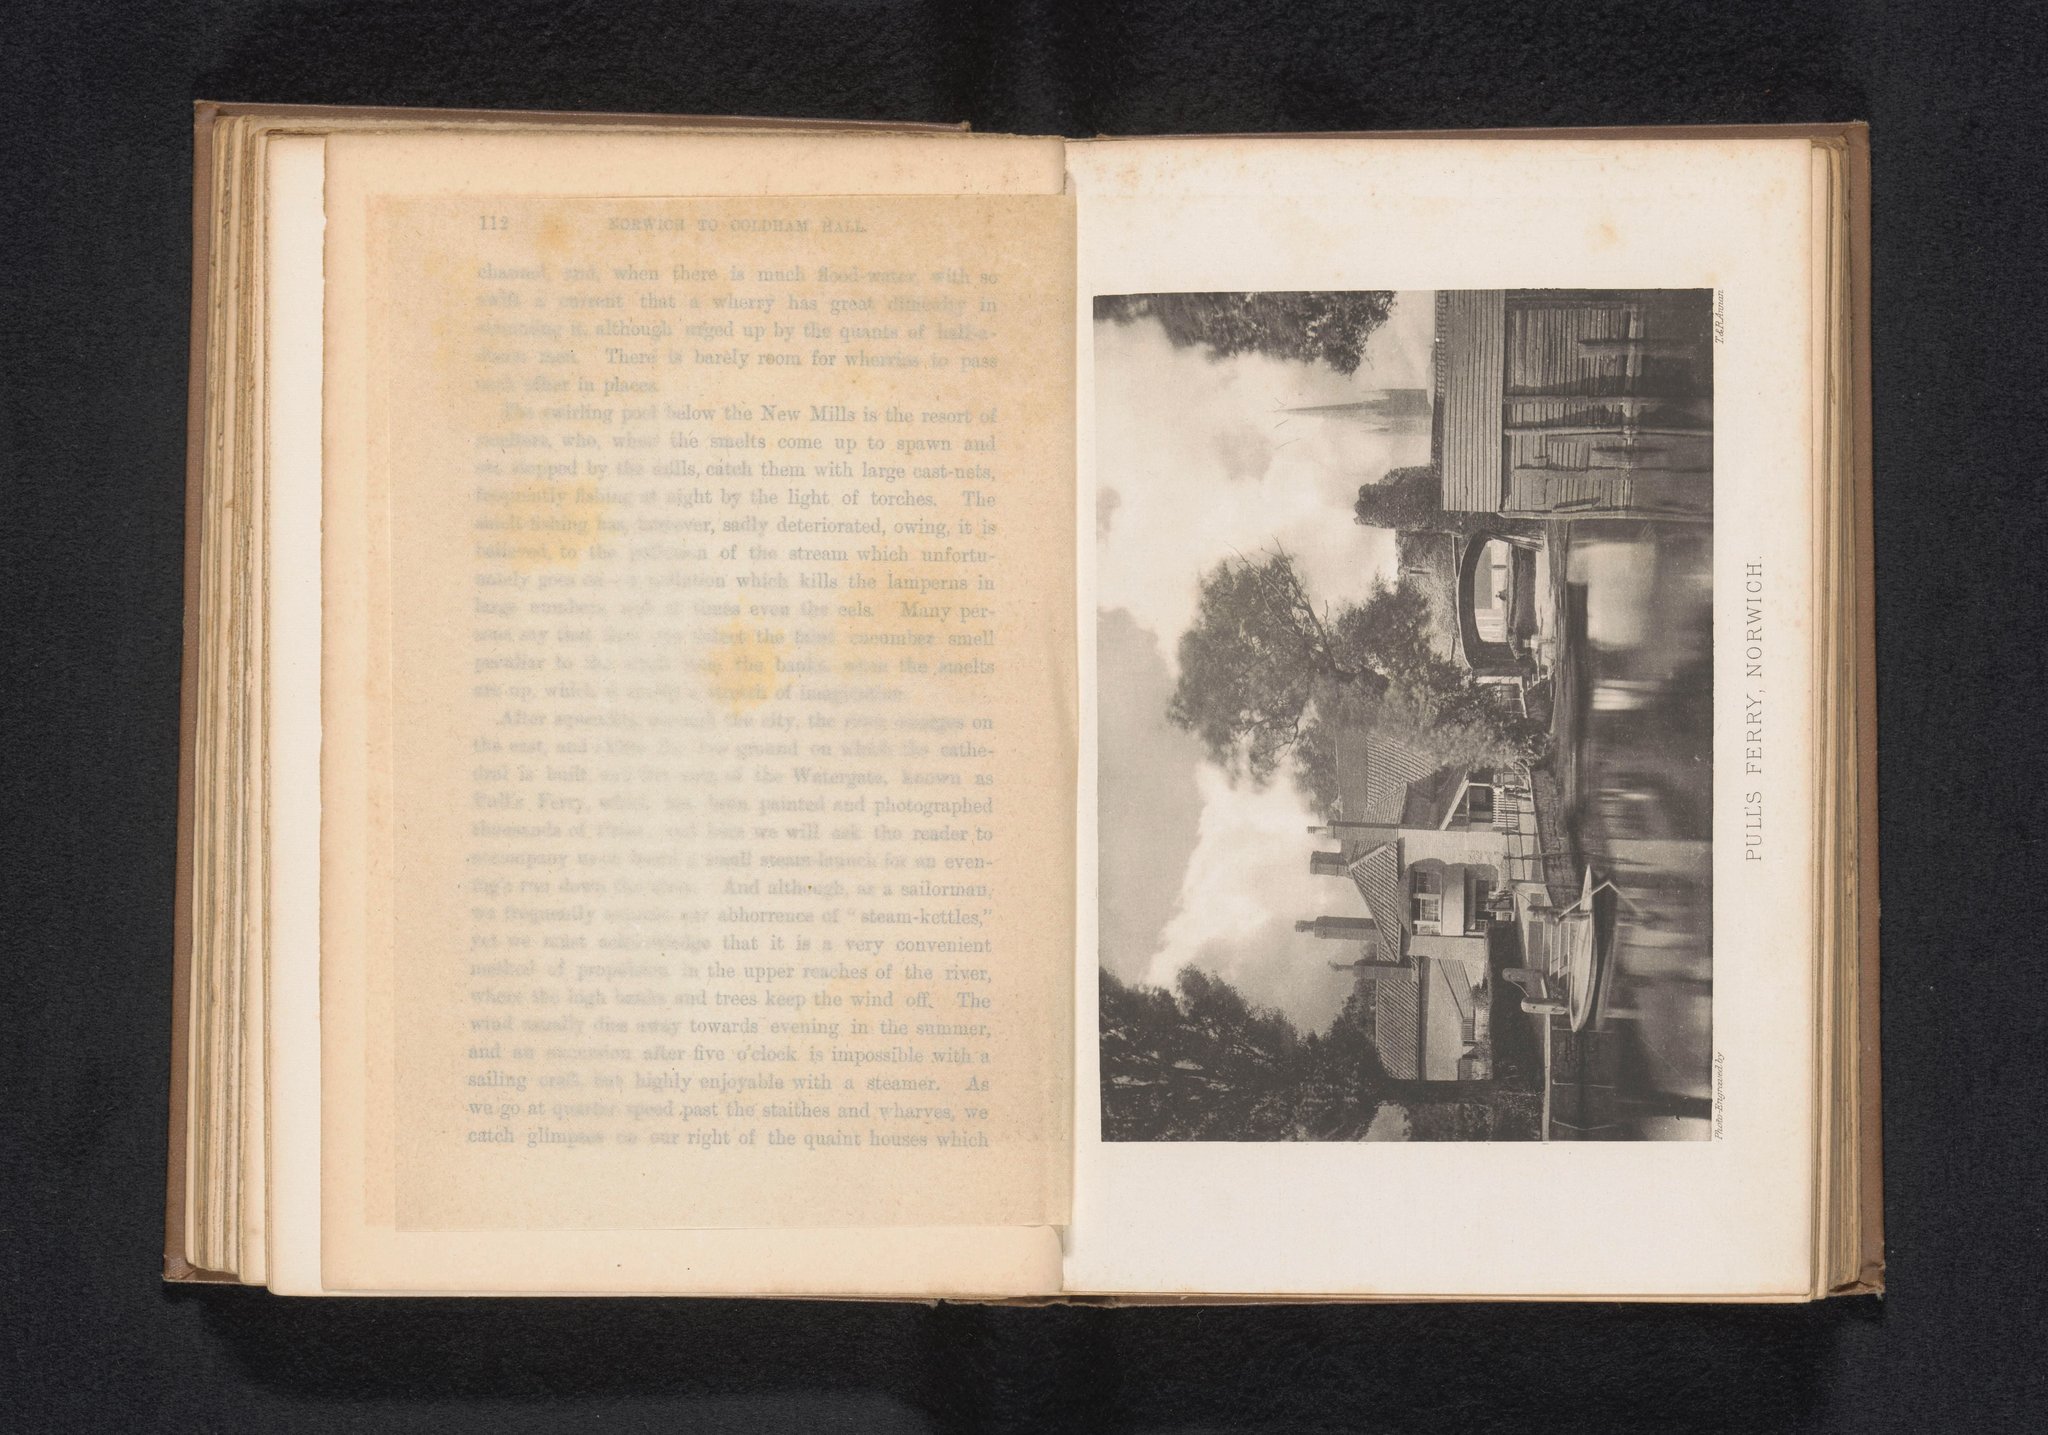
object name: page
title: Gezicht op Pulls Ferry te Norwich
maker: george christopher davies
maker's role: fotograaf, geoloog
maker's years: 1849-1922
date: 1878-1883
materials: paper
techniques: photoaquatint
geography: norwich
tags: city-view in general; 'veduta', ferry, façade (of house or building)